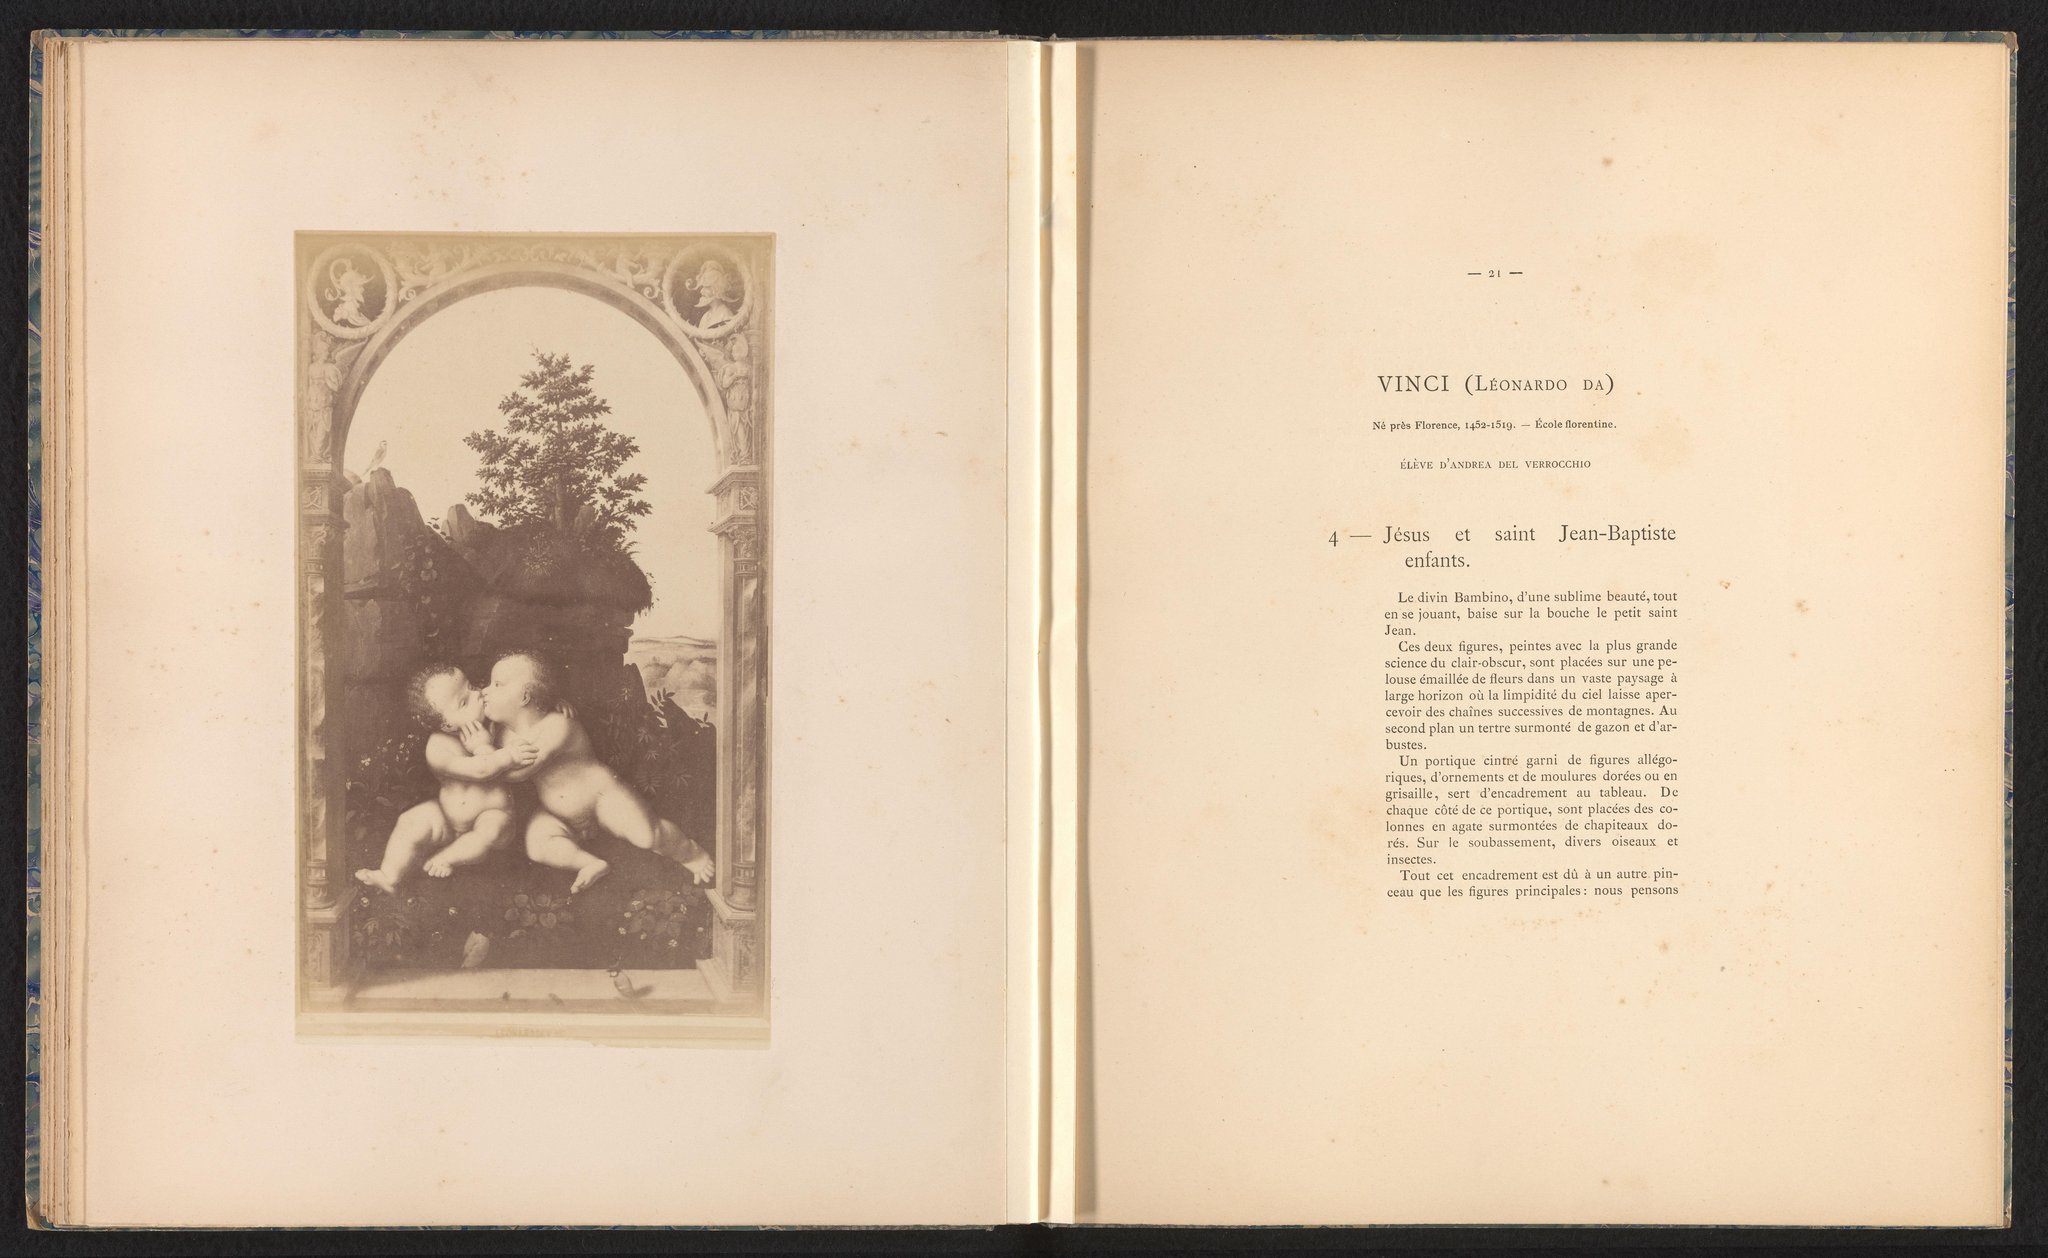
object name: page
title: Fotoreproductie van een schilderij met Jezus en de H. Johannes de Doper als kinderen door Leonardo da Vinci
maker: Anonymous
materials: paper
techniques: albumen print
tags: john the baptist as child ~ madonna-representations (n.b. secondary notation only), specific aspects of christ-child ~ madonna-representations (n.b. secondary notation only)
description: Foto op de 25e ongenummerde pagina na titelpagina.